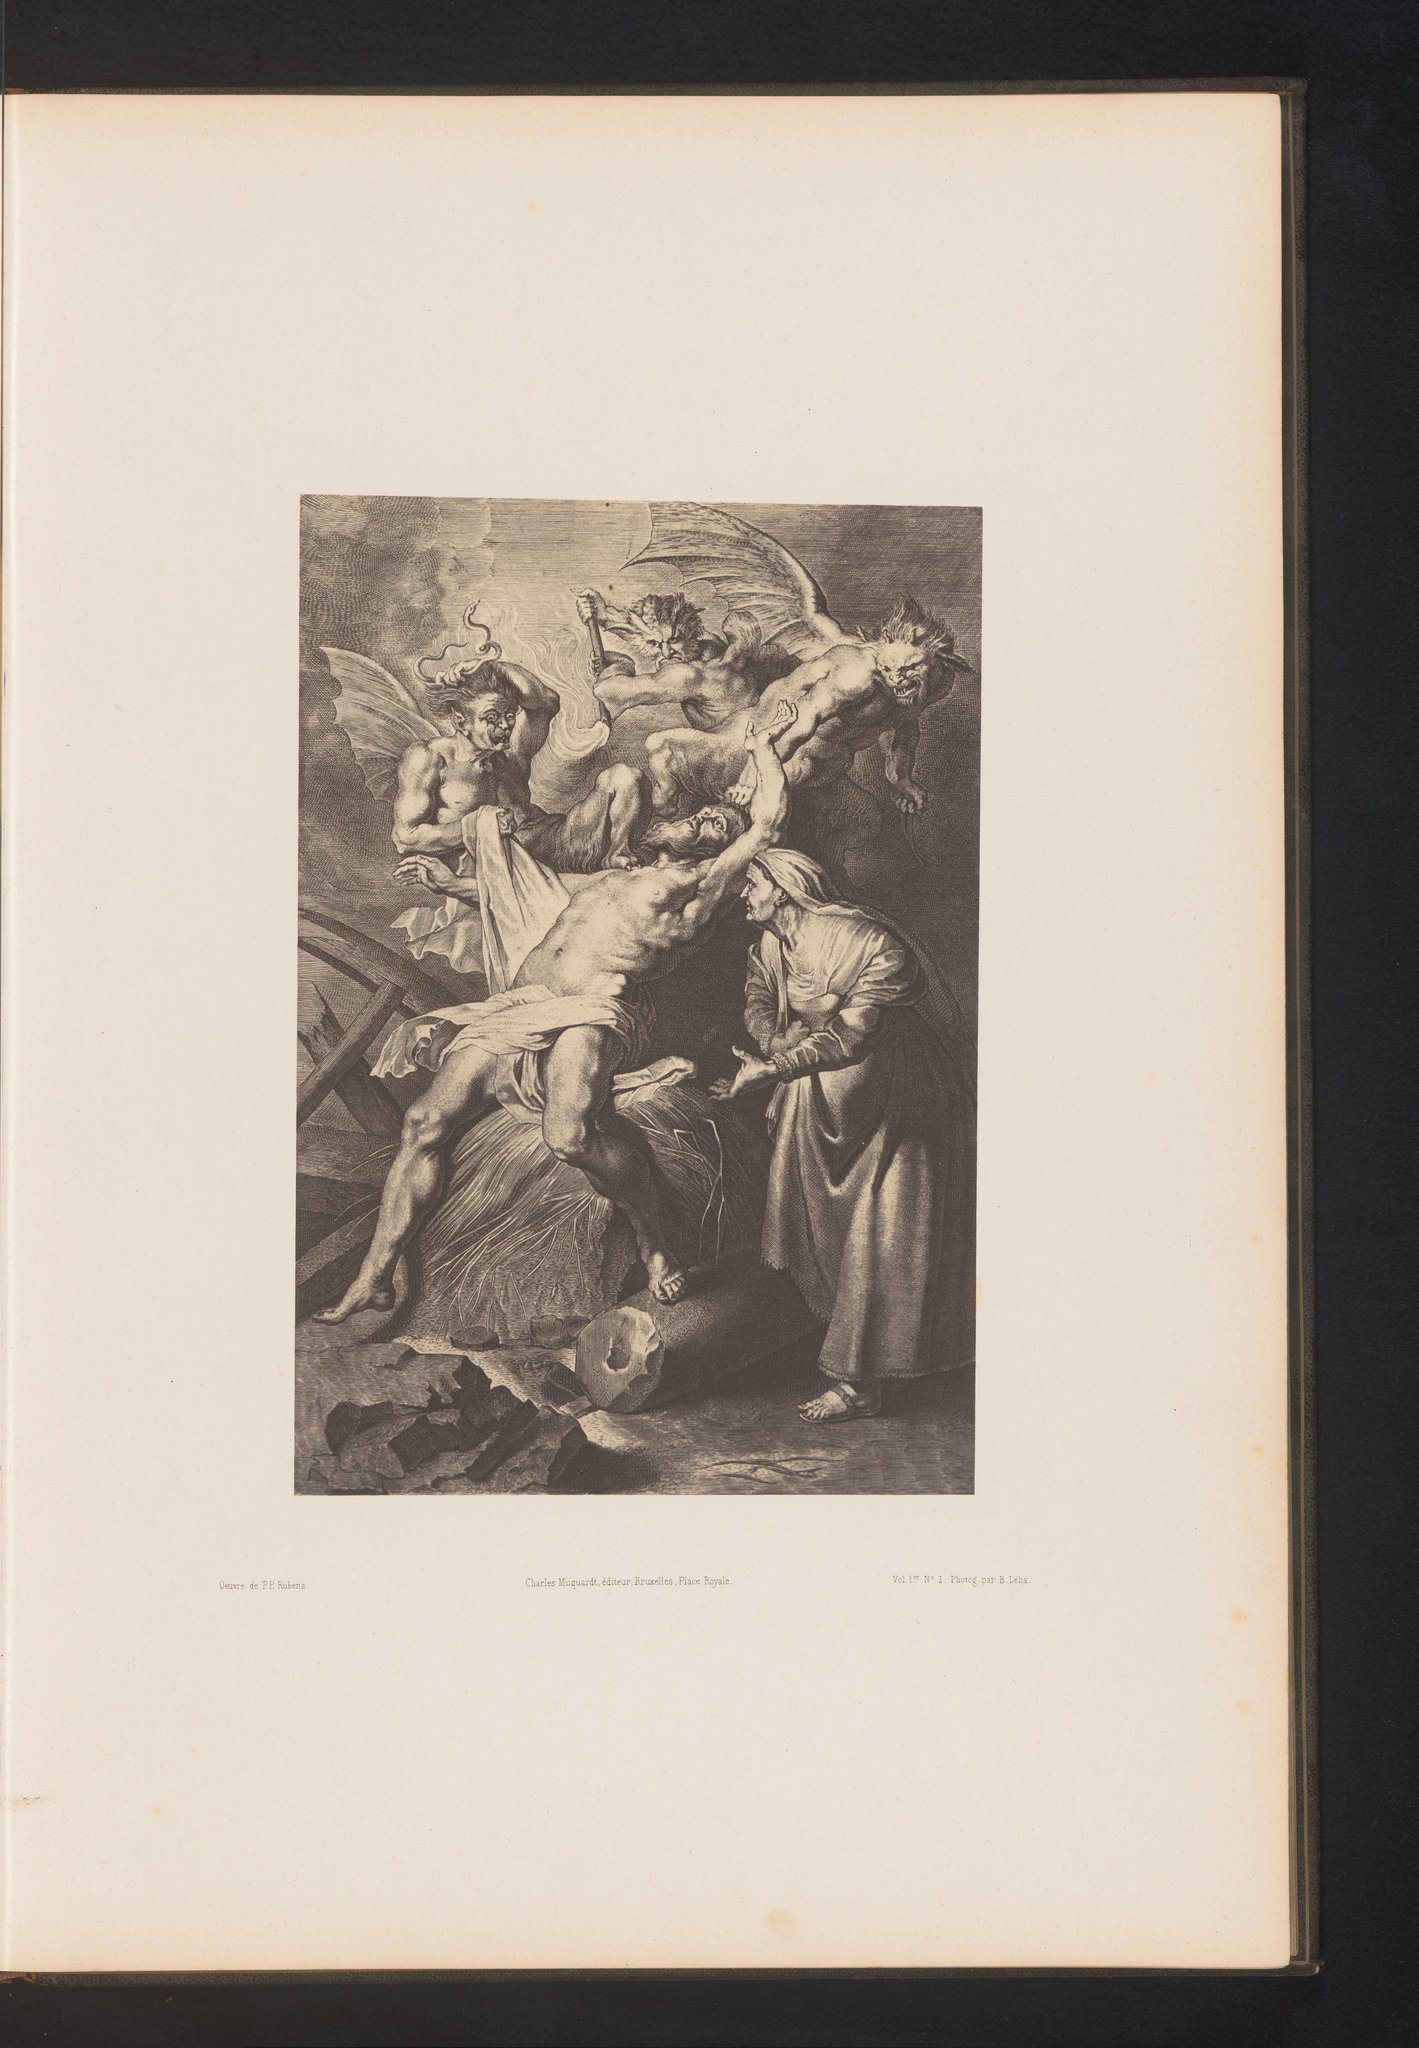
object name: reproduction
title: Oeuvre de P.P. Rubens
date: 1853-1858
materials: photographic support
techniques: albumen print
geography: brussels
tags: job's wife abusing him; satan may be present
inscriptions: number: ‘Vol. 1er. No 2.’